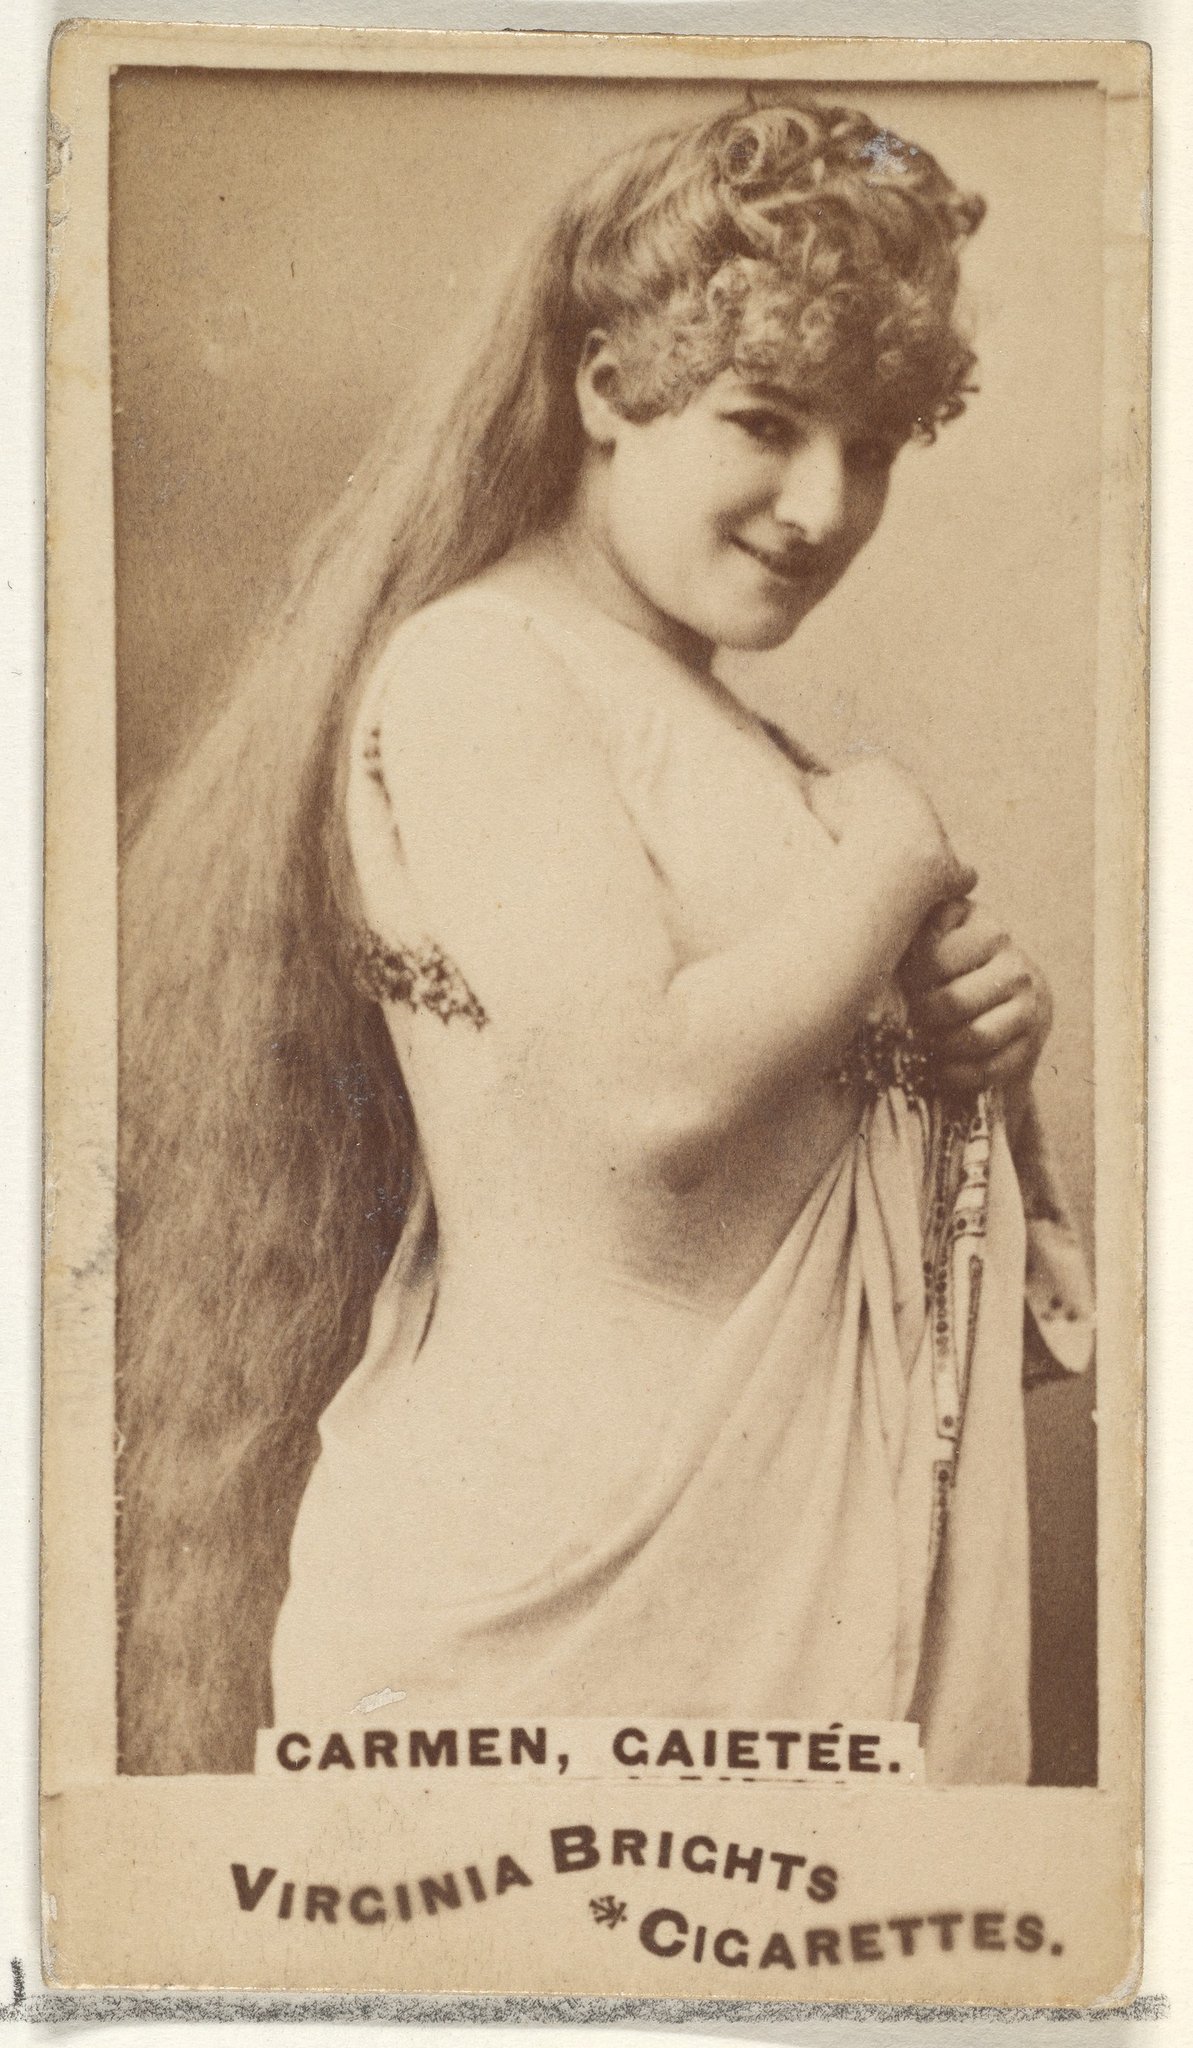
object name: photograph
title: Carmen, Gaietée, from the Actors and Actresses series (N45, Type 1) for Virginia Brights Cigarettes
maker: allen & ginter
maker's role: publisher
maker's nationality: american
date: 1888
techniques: albumen silver print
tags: portraits,women,actresses